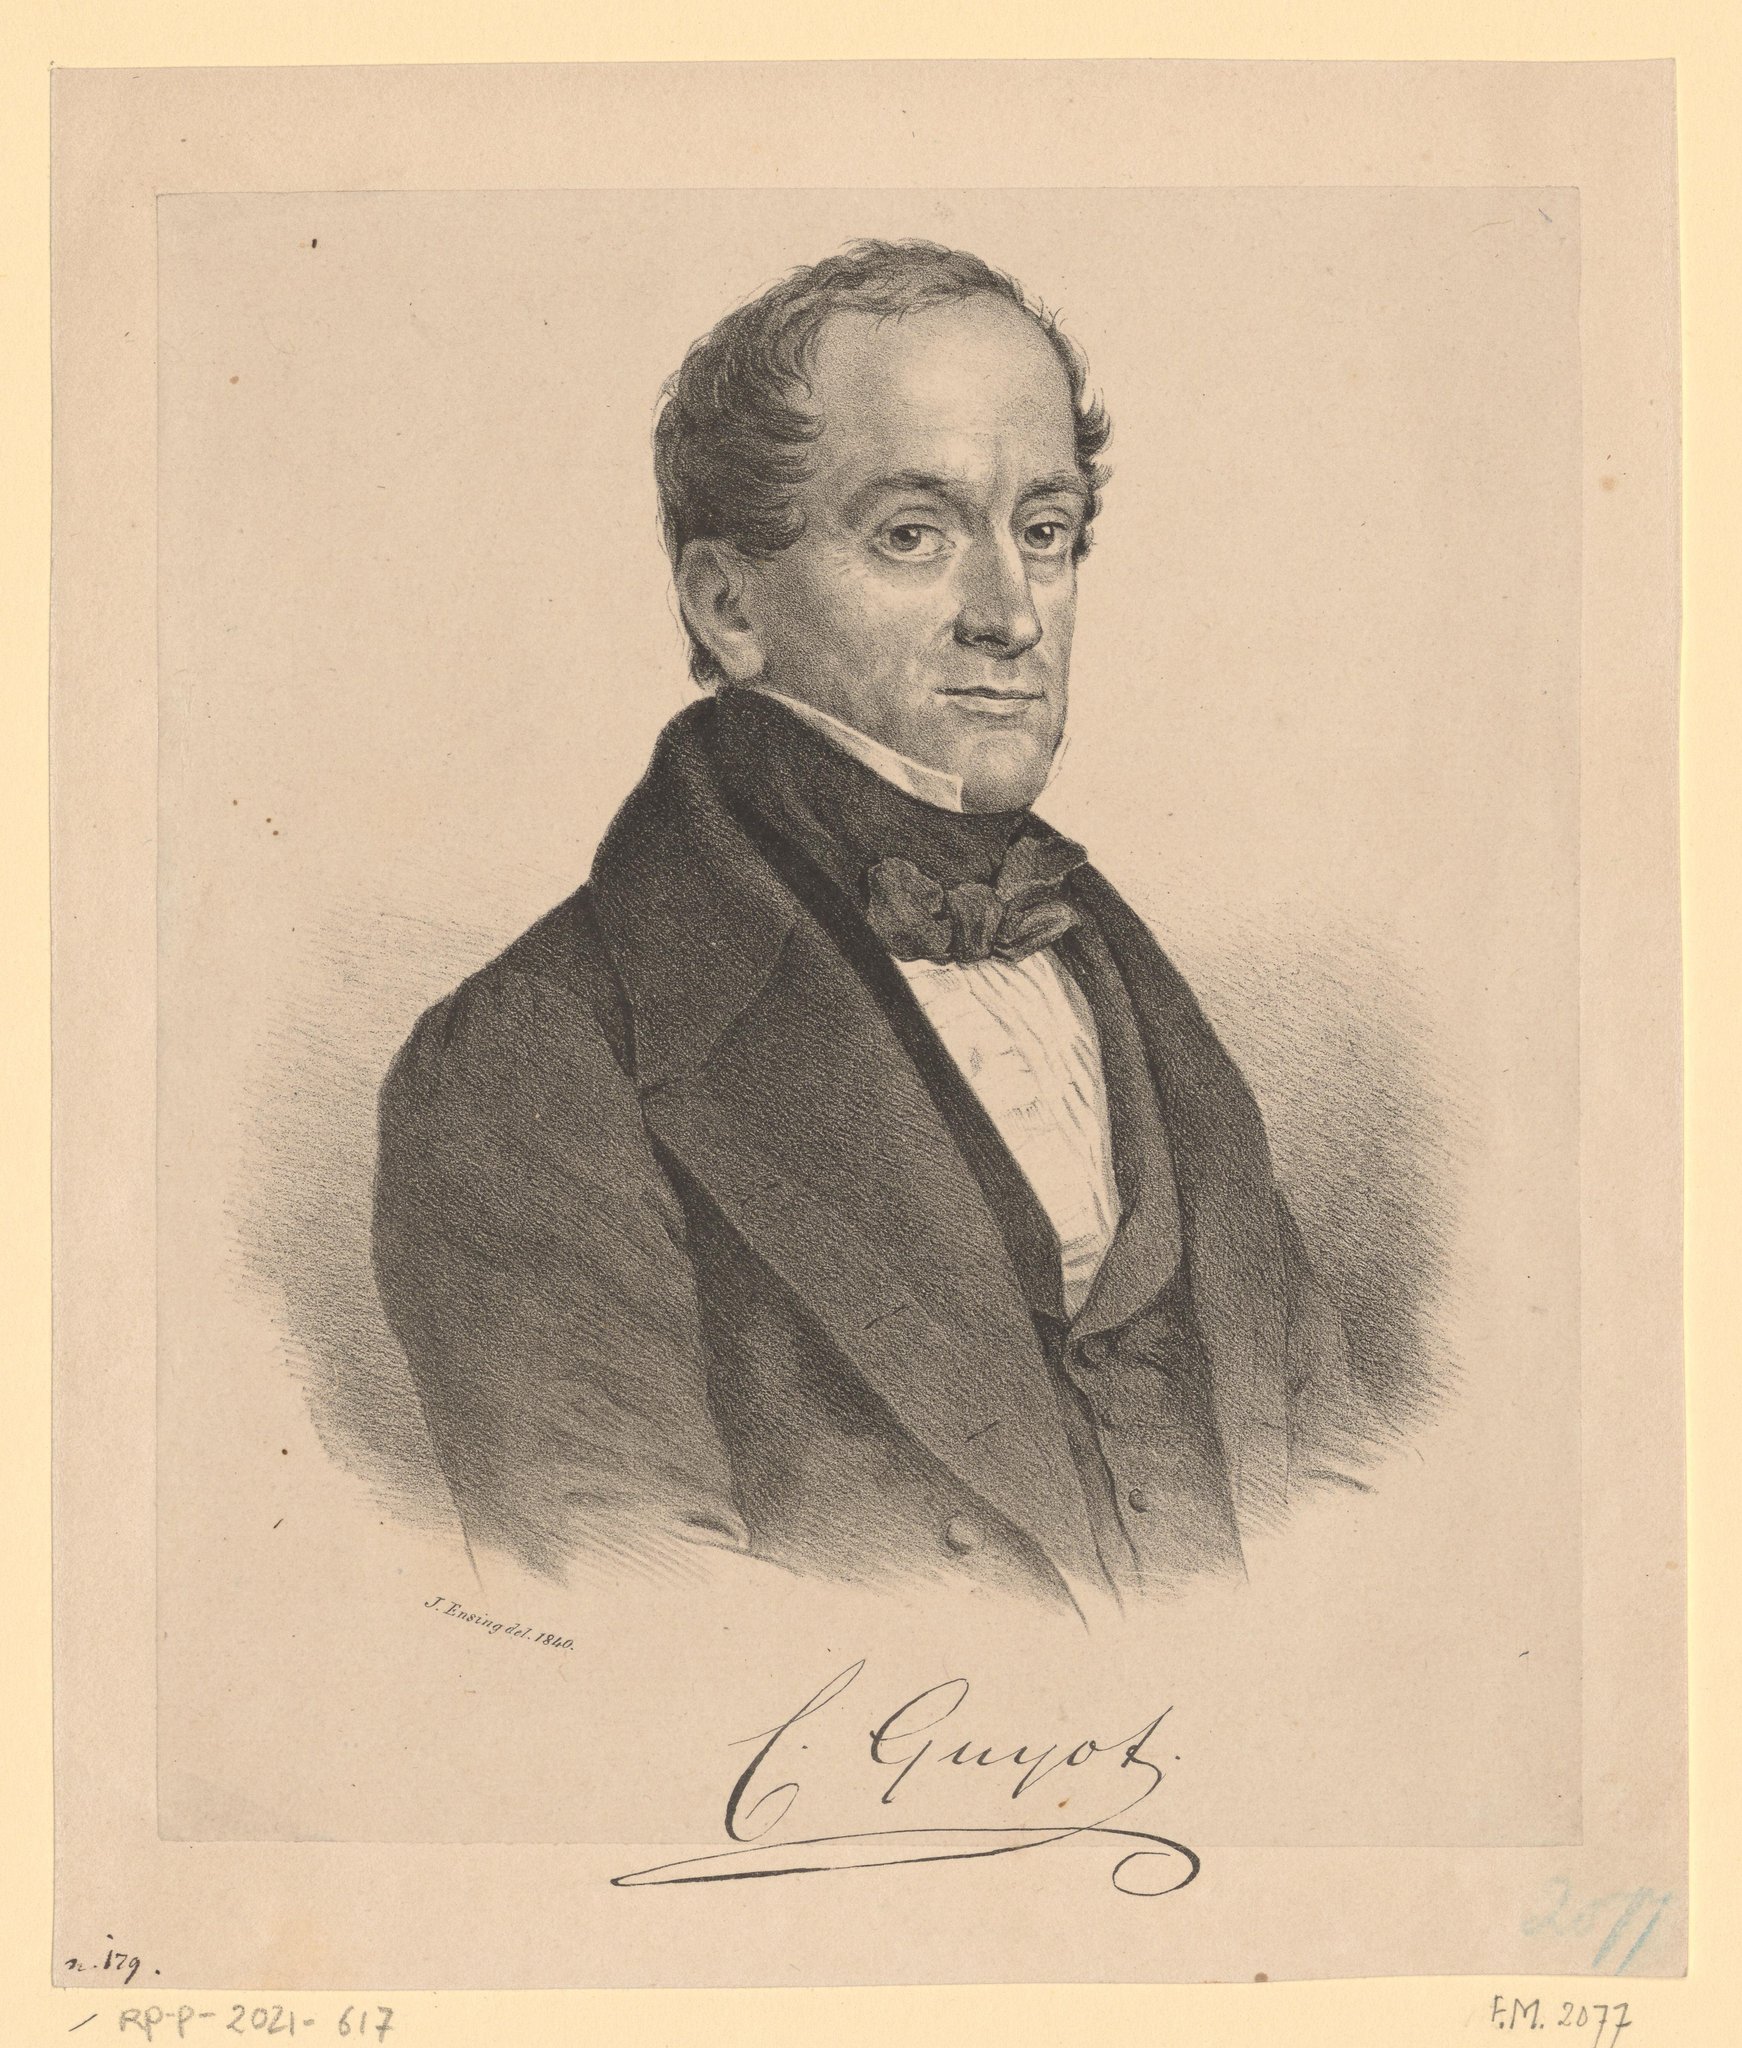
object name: print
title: Portret van Charles Guyot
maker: jan ensing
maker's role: draughtsman, painter, print maker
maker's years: 1819-1894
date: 1840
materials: paper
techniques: lithograph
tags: historical persons, education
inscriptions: date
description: Een facsimile signatuur in de ondermarge.